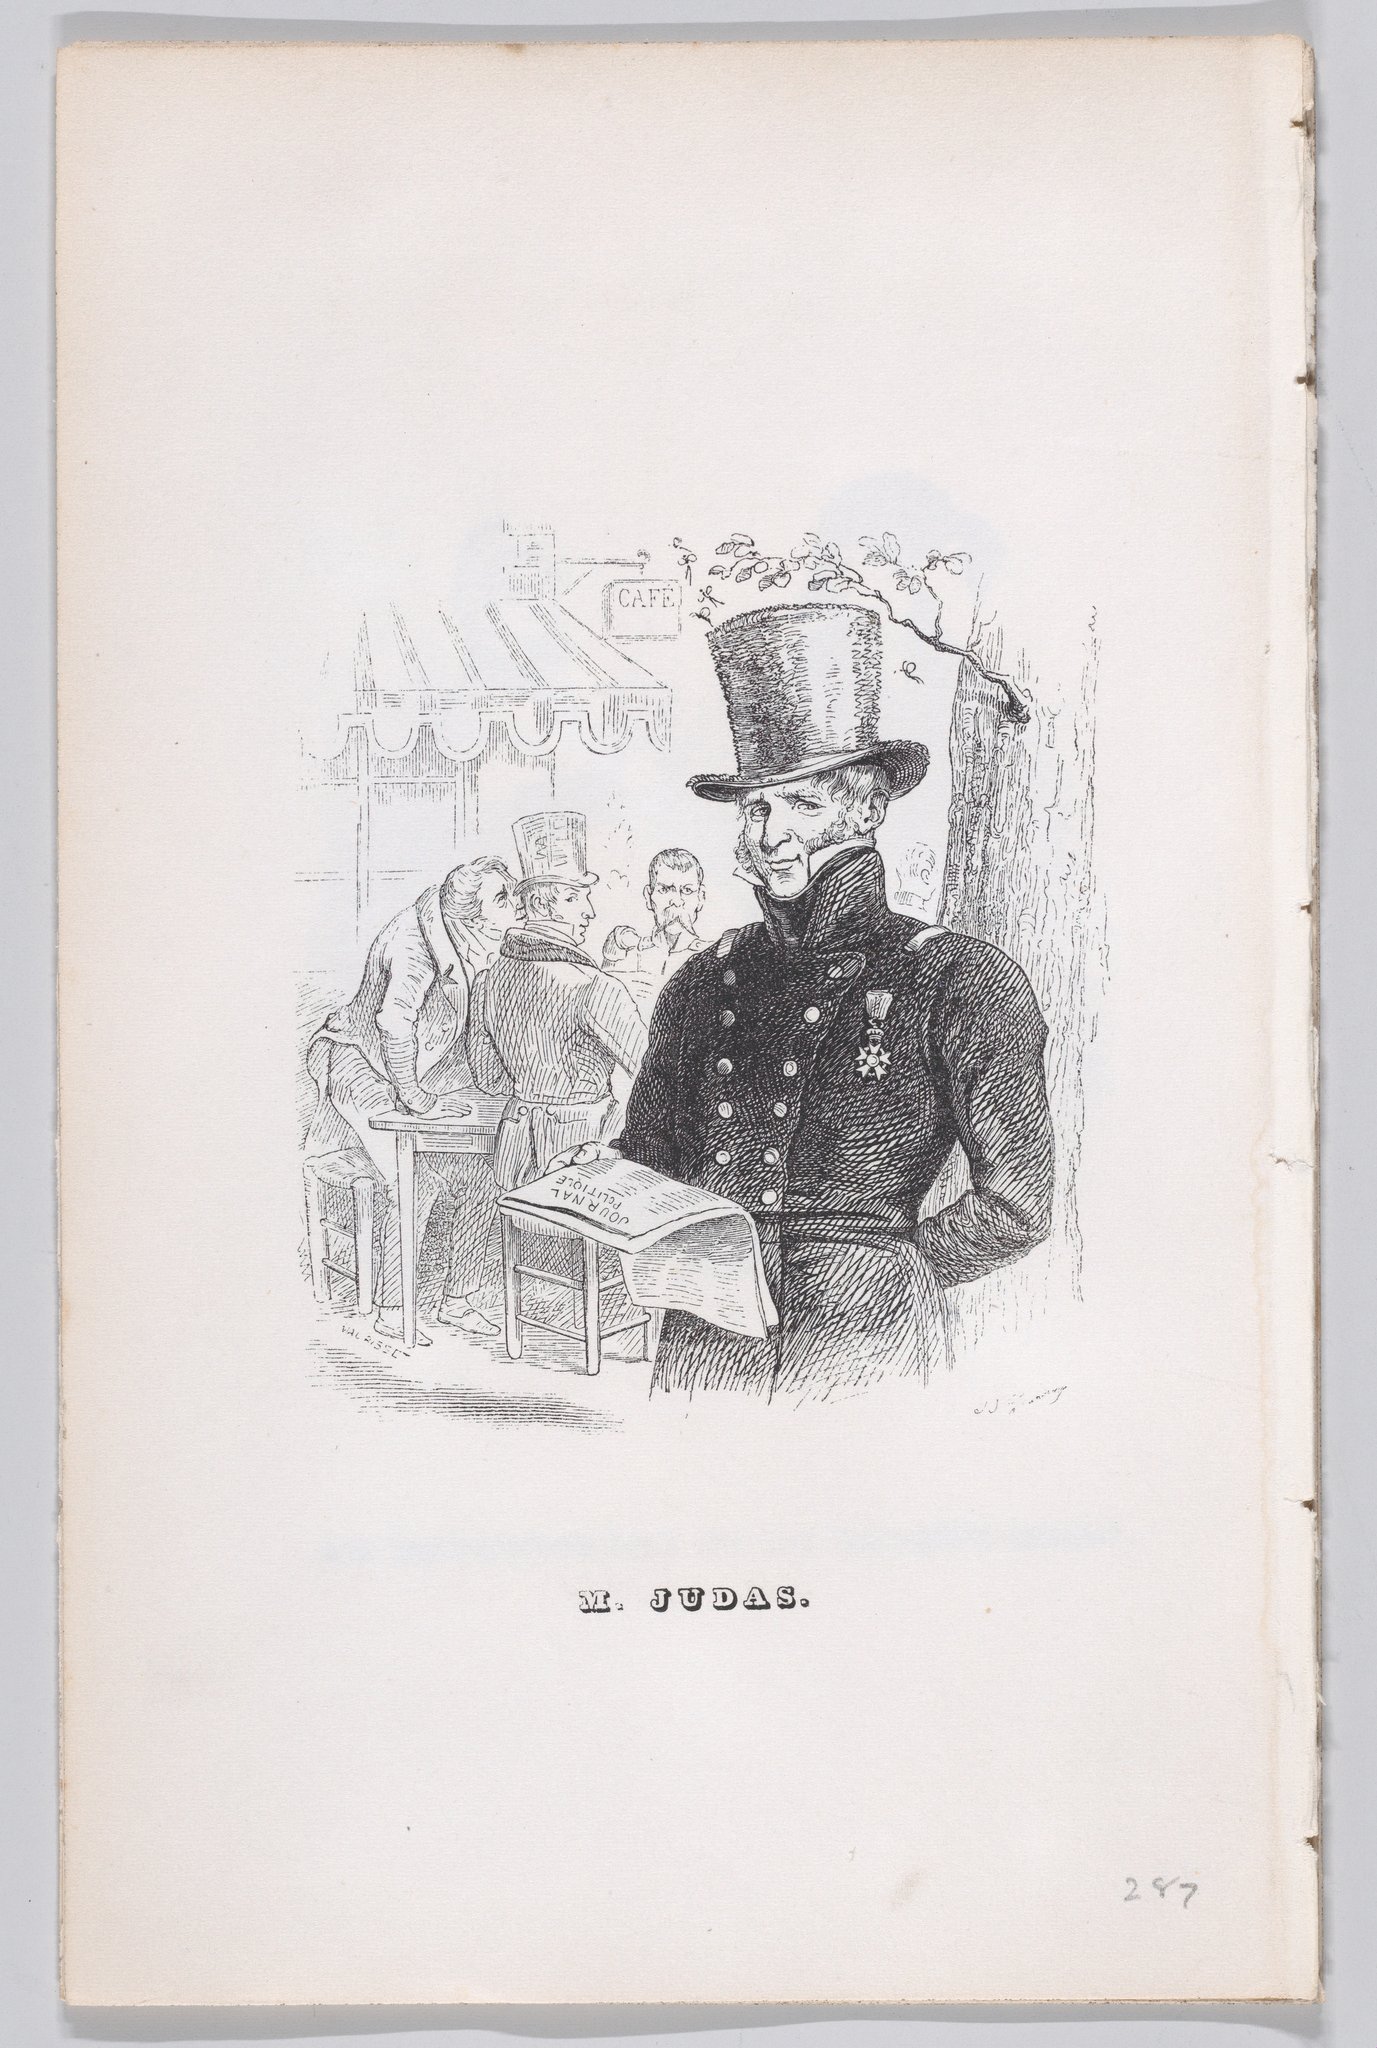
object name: print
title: Mr. Judas, from "The Complete Works of Béranger"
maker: j. j. grandville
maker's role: illustrator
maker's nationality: french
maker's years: 1803-1847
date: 1836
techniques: engraving